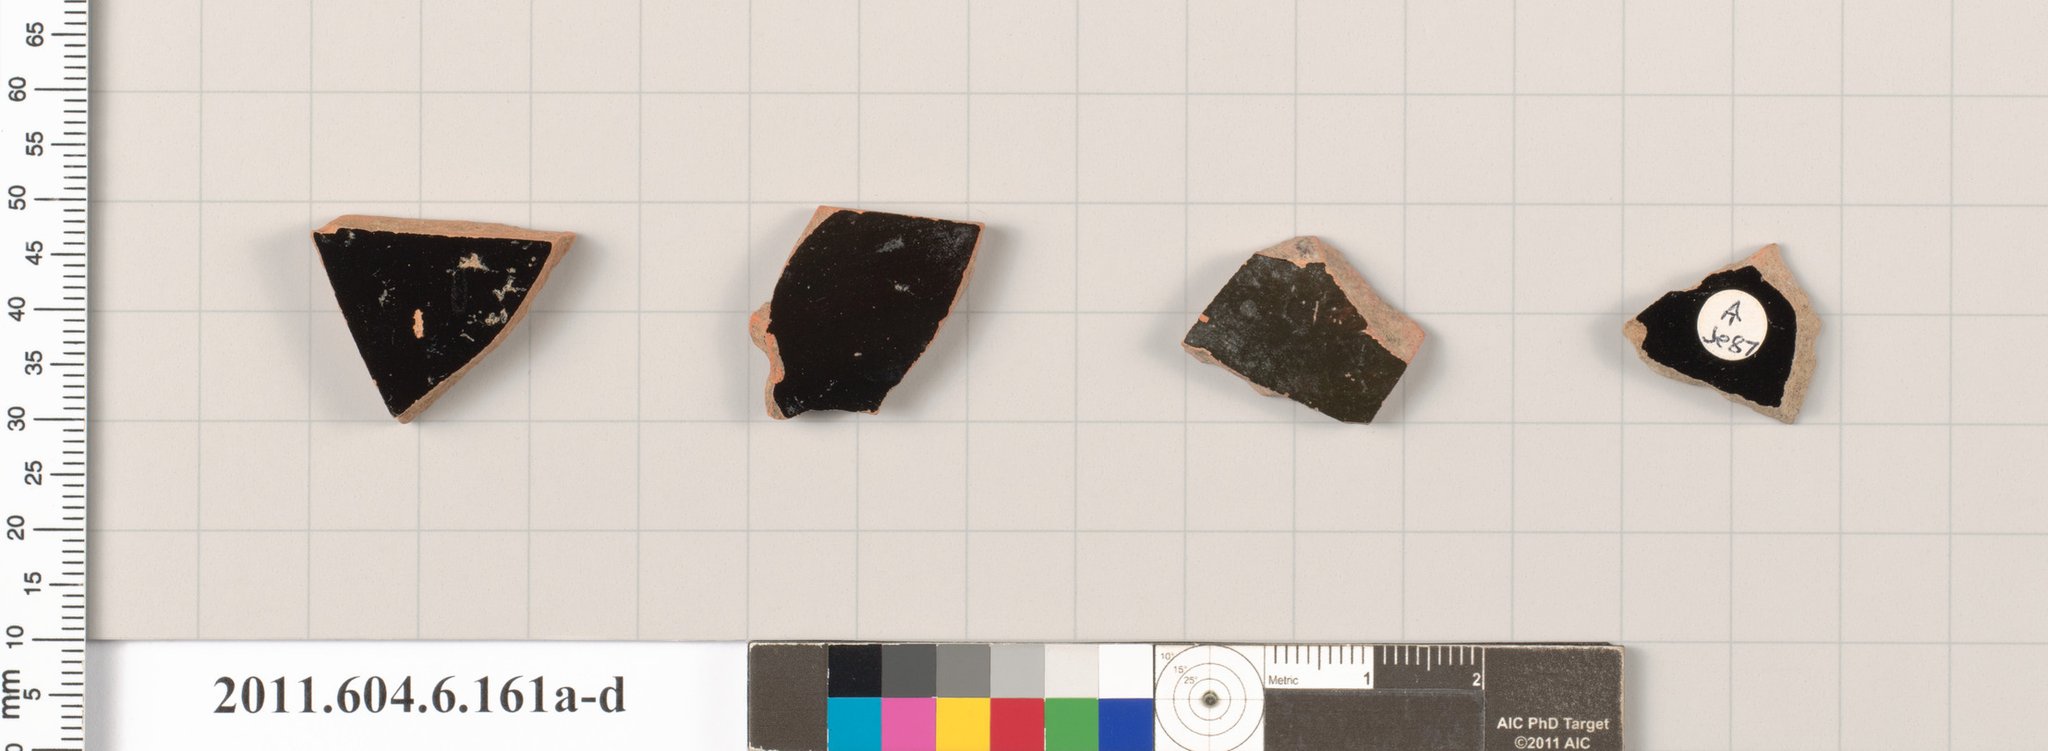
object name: undetermined open shape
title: Terracotta fragments of open shapes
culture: greek, attic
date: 600-401 BCE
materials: terracotta